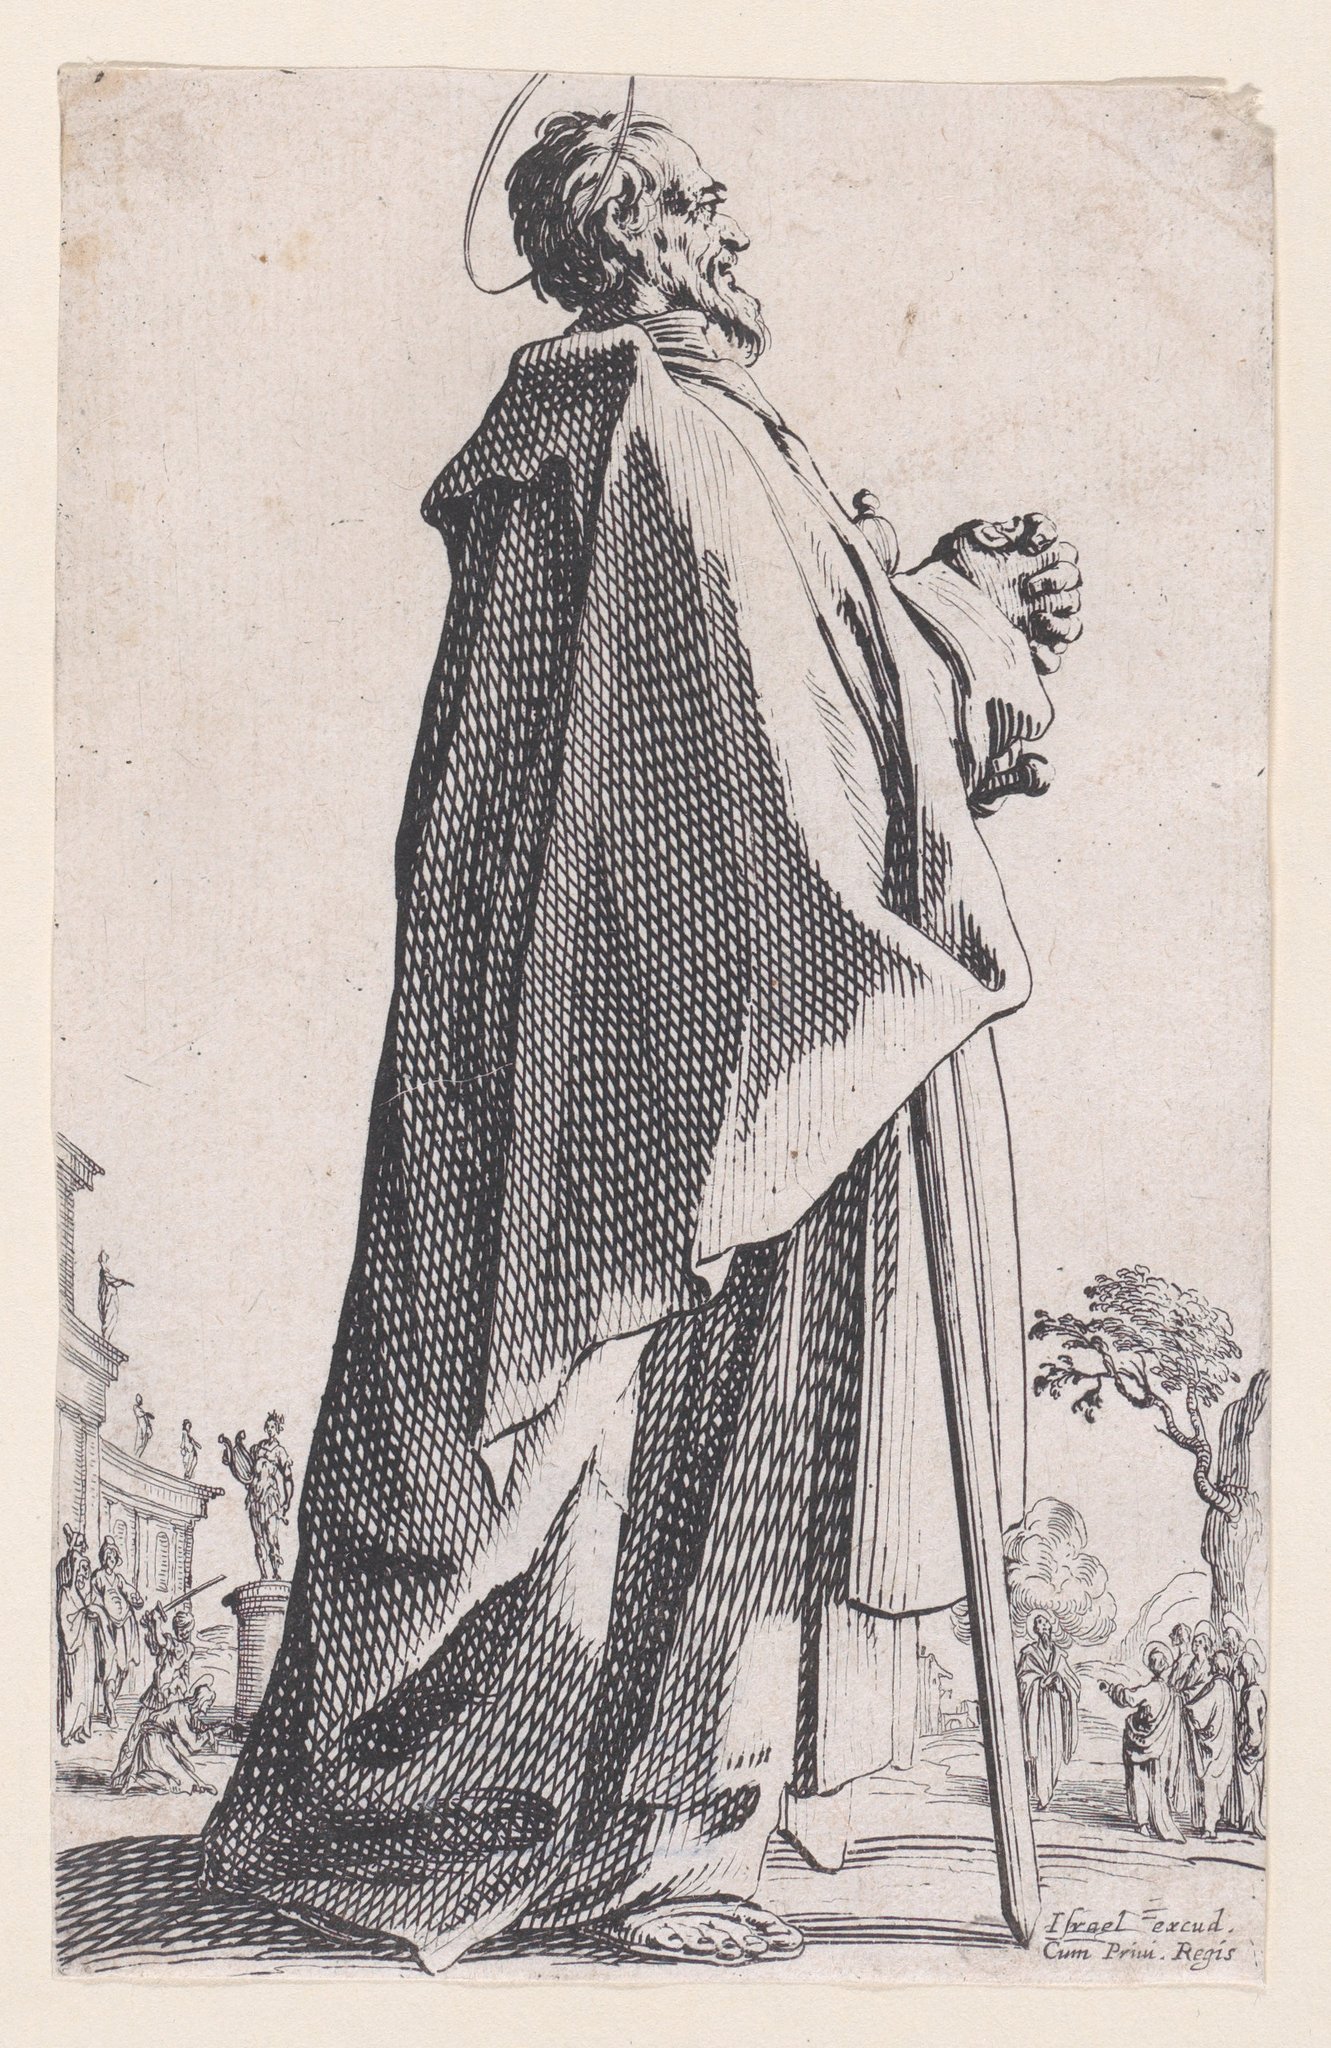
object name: print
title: St. Matthew, from "Les Grands Apôtres Debout, Représentant Le Sauveur, La Bienheureuse Marie et Les Saints Apôtres" (The Large Standing Apostles, Representing The Savior, The Blessed Mary and The Apostles)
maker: jacques callot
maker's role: artist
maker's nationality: french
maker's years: 1592-1635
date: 1631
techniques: etching